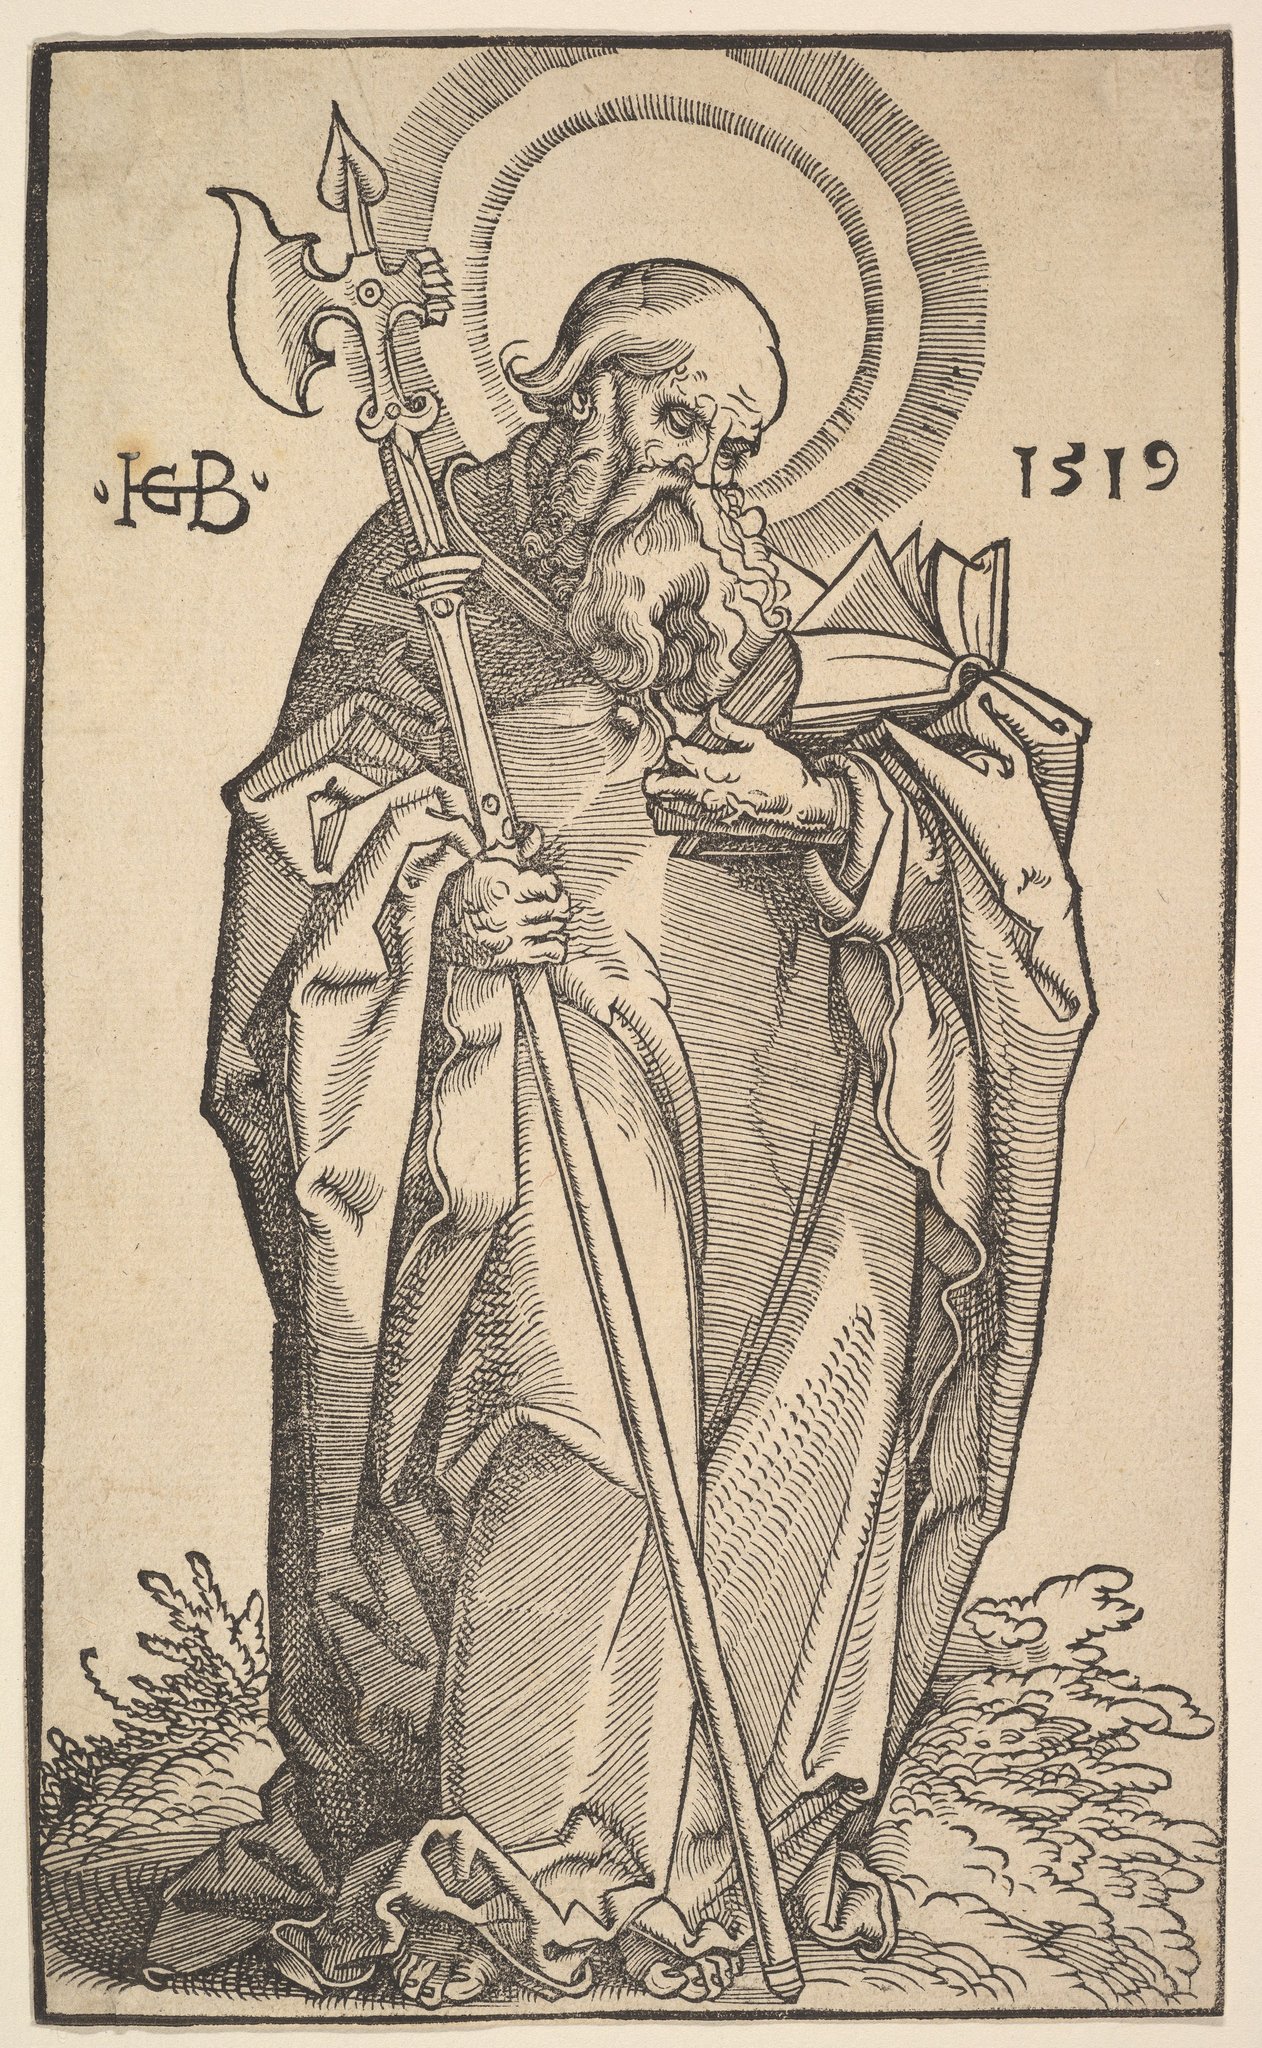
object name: print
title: St. Matthew, from "Christ and the Apostles"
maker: hans baldung (called hans baldung grien)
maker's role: artist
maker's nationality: german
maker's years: 1484-1545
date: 1519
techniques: woodcut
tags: books,weapons,saint matthew